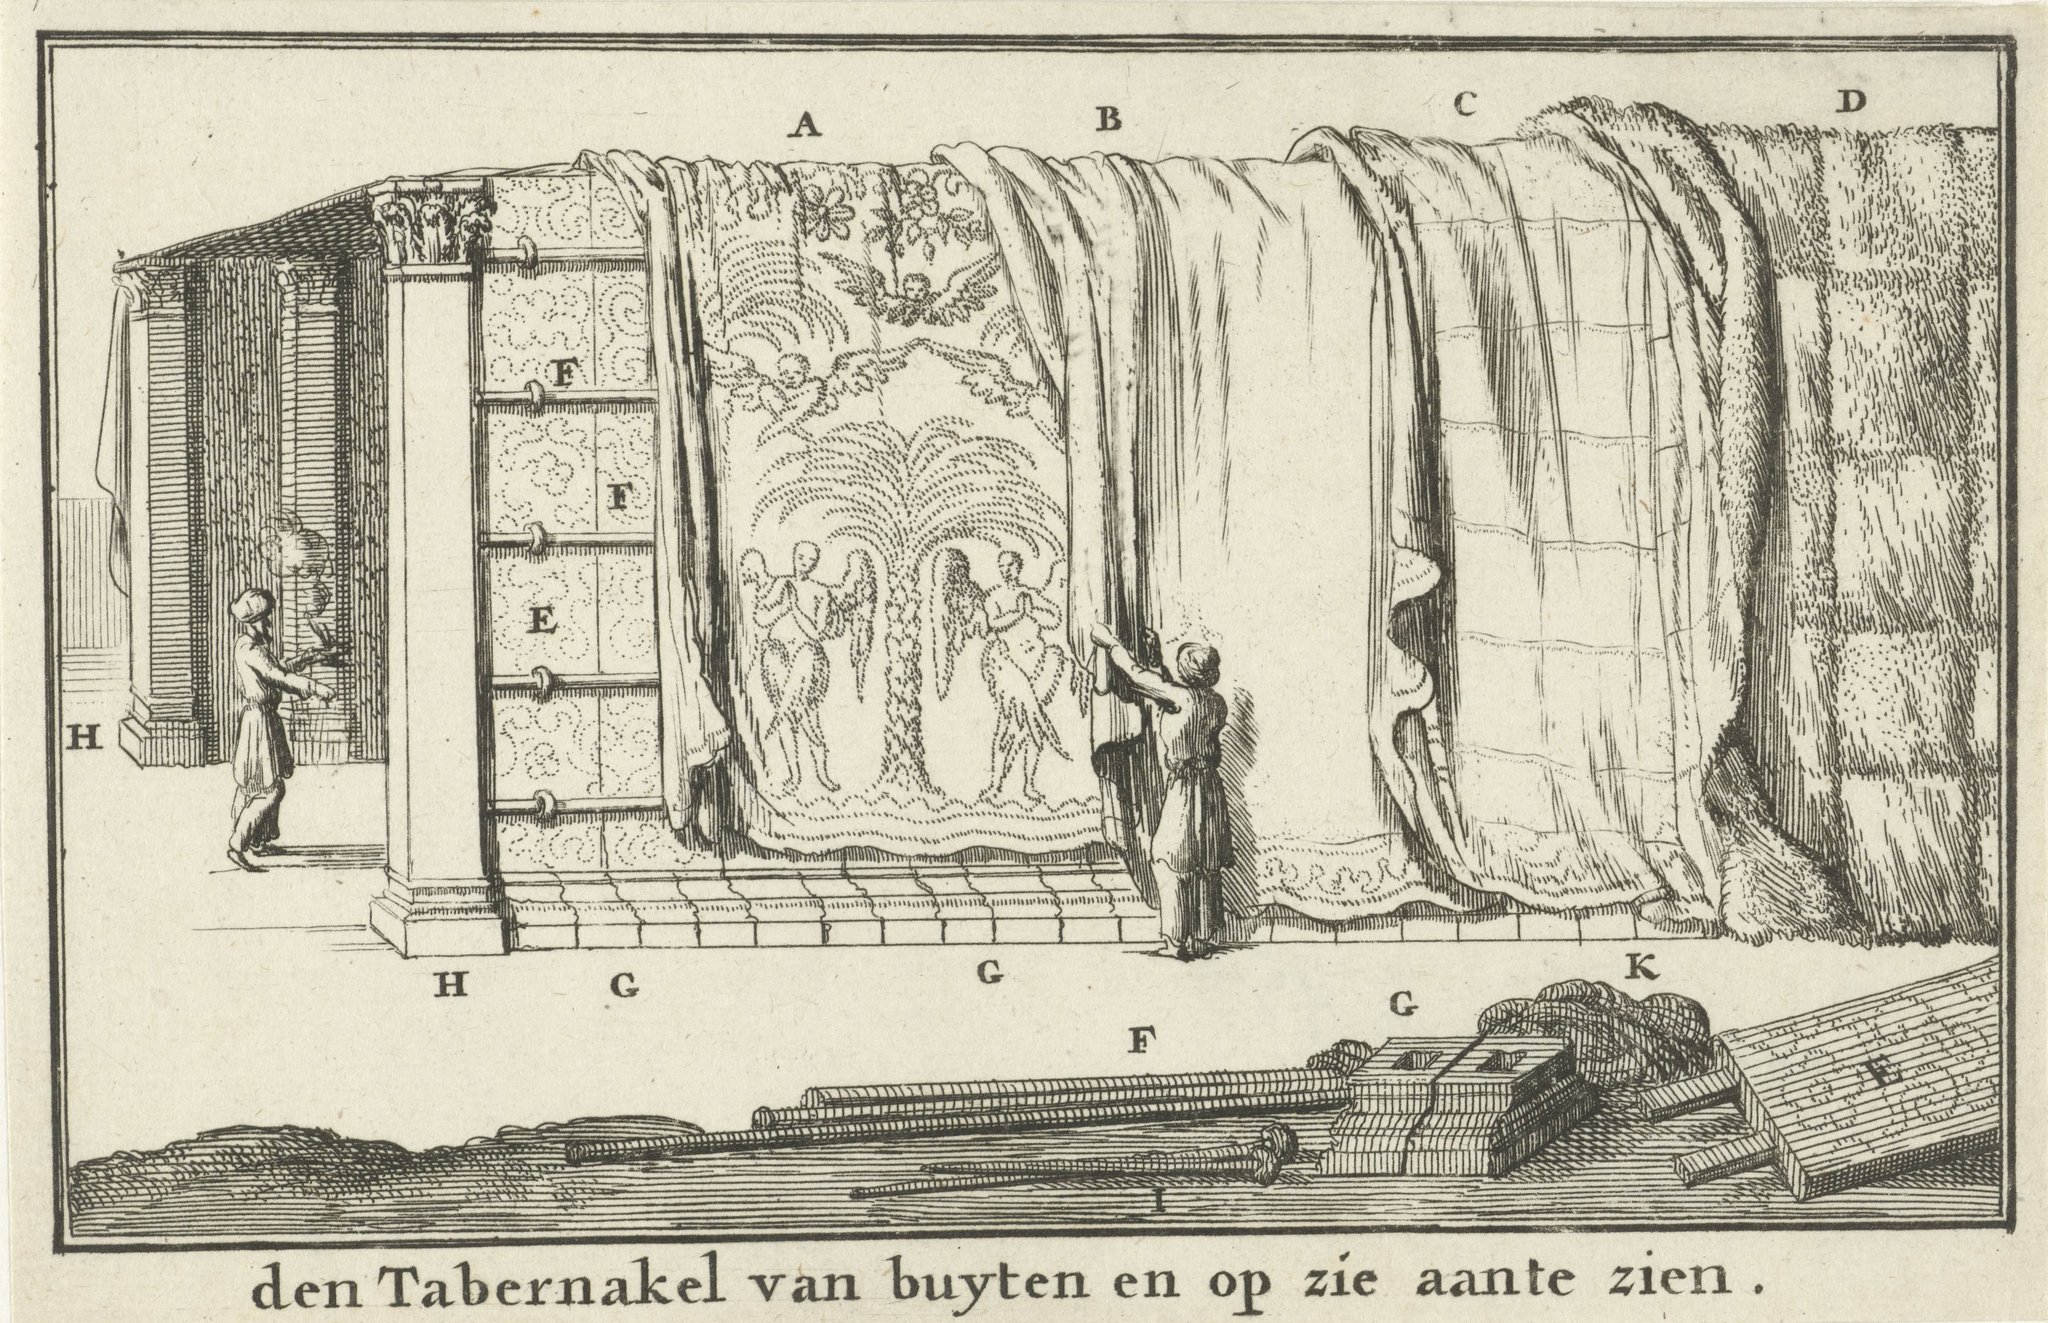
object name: book illustration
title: Den Tabernakel van buyten en op zie aante zien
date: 1683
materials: paper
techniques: etching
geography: amsterdam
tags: the making of the tabernacle and its accessories ~ exodus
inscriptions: collector's mark: Lugt 2228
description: Latere staat van deze illustratie opgenomen in: Cunaeus, Petrus. De republyk der Hebreen, of gemeenebest der joden, 3 delen. Amsterdam: Wilhelmus Goeree, 1683, dl. 2, p. 476.